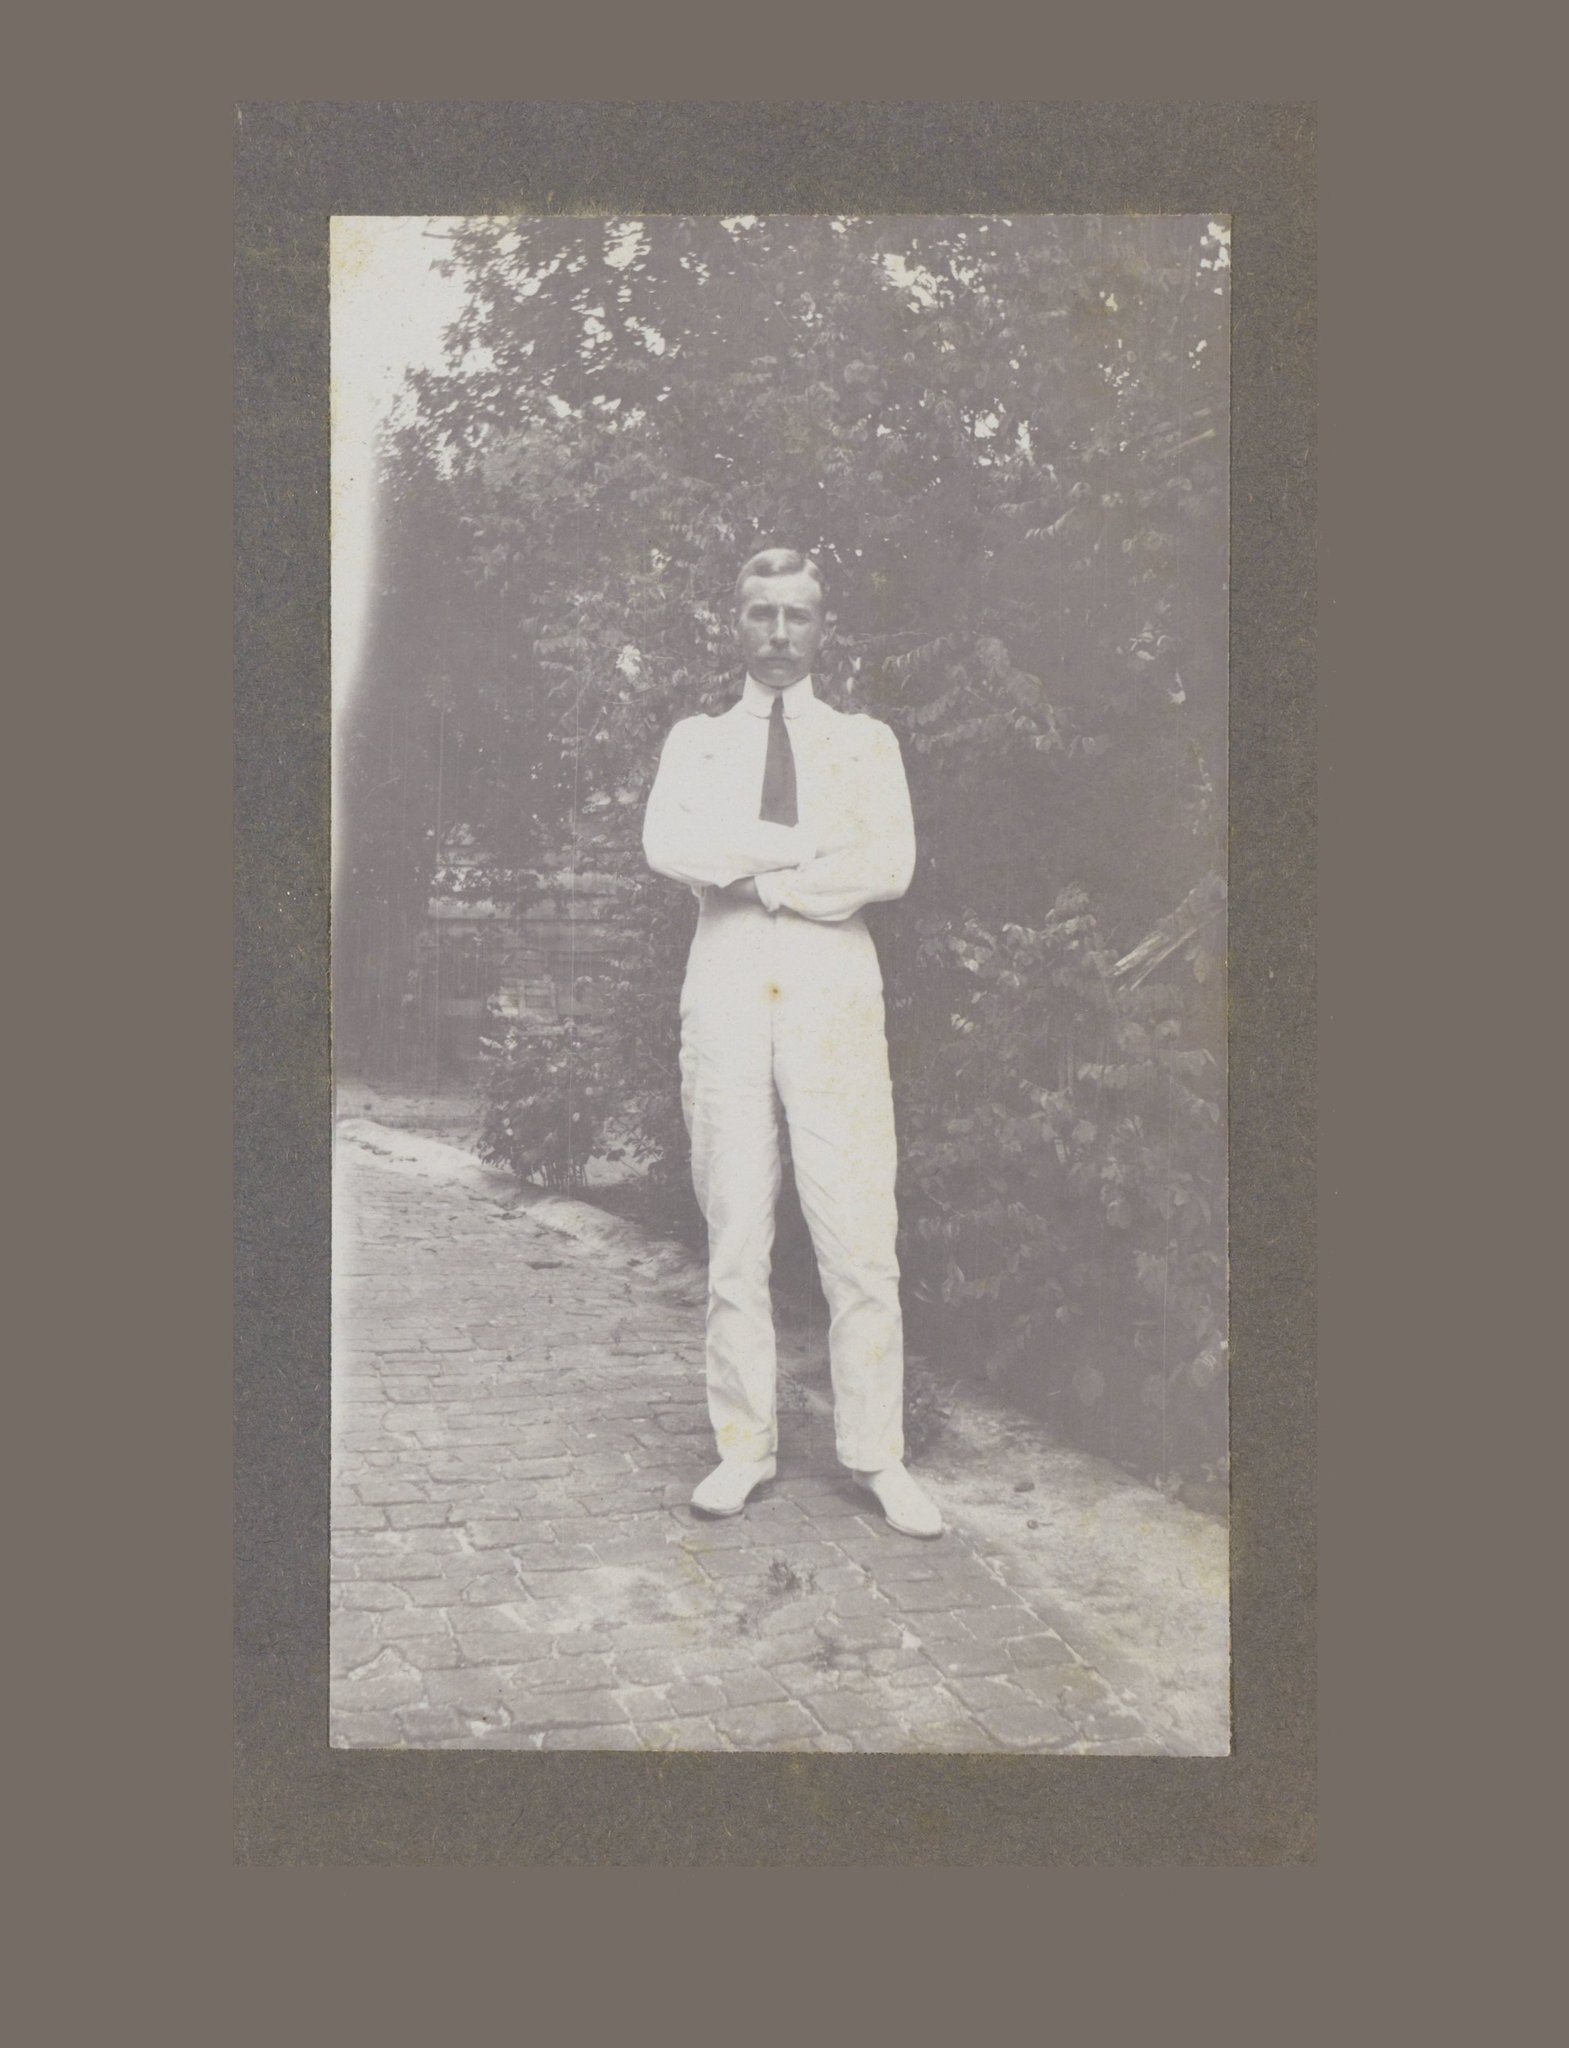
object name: photograph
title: Andries Boom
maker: Anonymous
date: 1911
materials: photographic support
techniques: photography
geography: suriname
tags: andries augustus boom, suriname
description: Andries Boom staande met zijn armen over elkaar. Onderdeel van het fotoalbum over het leven van de familie Gonggrijp in Suriname rond 1912.